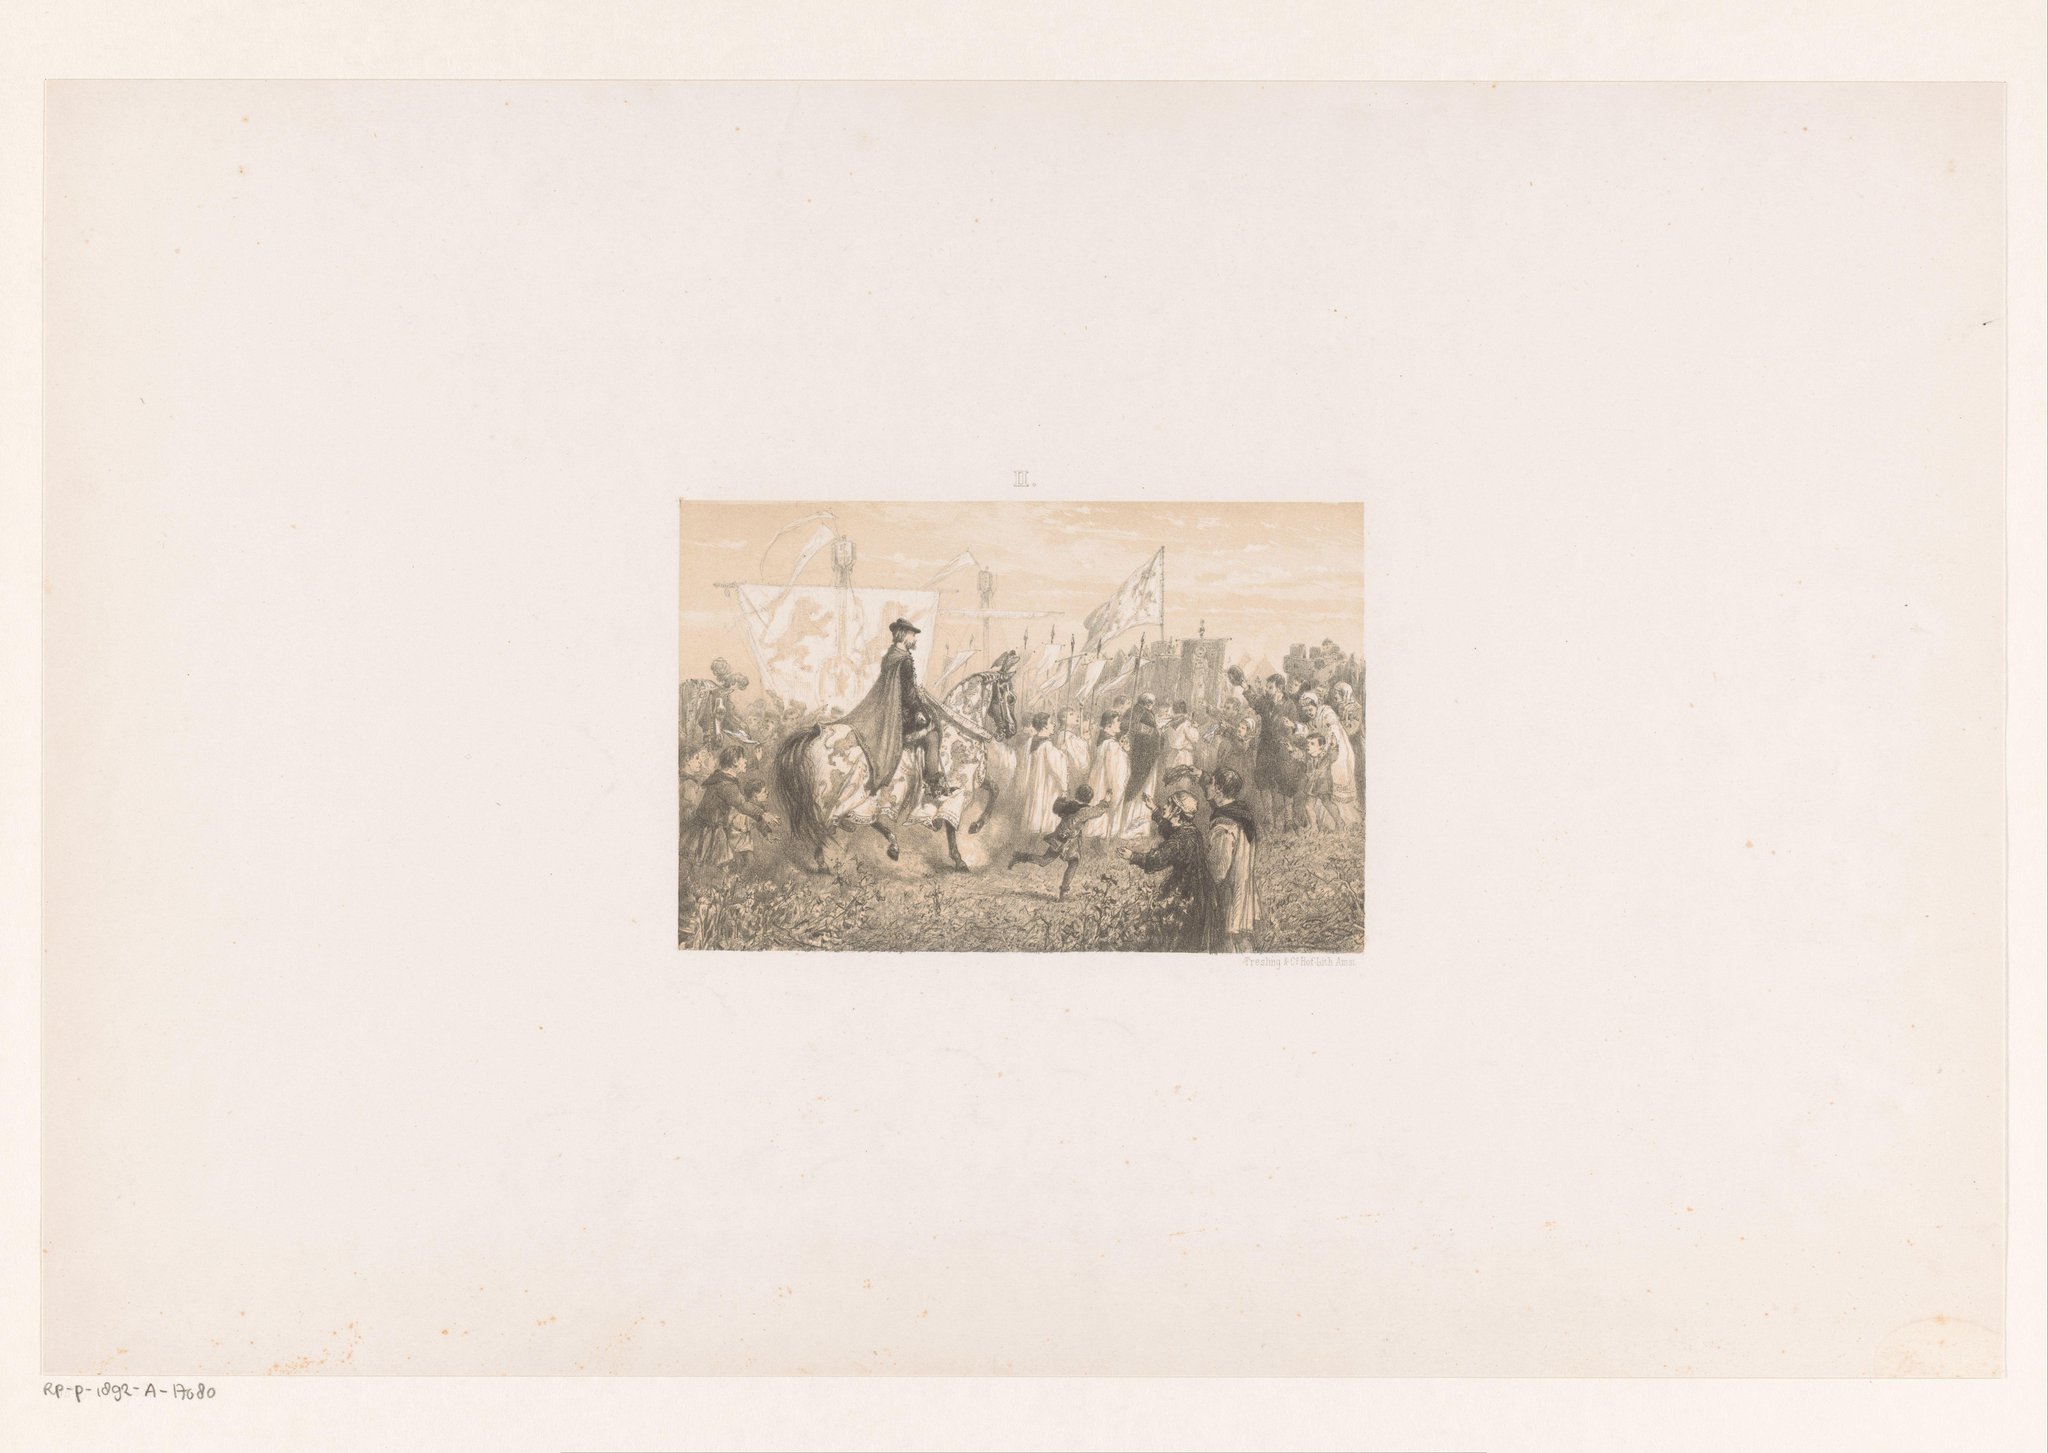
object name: print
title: Aankomst van Gwy van Henegouwen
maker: johan conrad greive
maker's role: draughtsman, painter, print maker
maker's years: 1837-1891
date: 1876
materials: paper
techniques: tone lithography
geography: amsterdam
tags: crowd, mob, sailing-ship, sailing-boat, organization, functionaries and dignitaries in roman catholic church; clergy in general, knight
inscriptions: collector's mark: Lugt 2228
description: Gwy van Henegouwen, te paard, wordt begeleid door geestelijken en misdienaren. Zij dragen vaandels. In de achtergrond zijn de zeilen van zeilschepen zichtbaar. De stoet gaat een kampement binnen. Bij de ingang staat een menigste zwaaiende mensen.